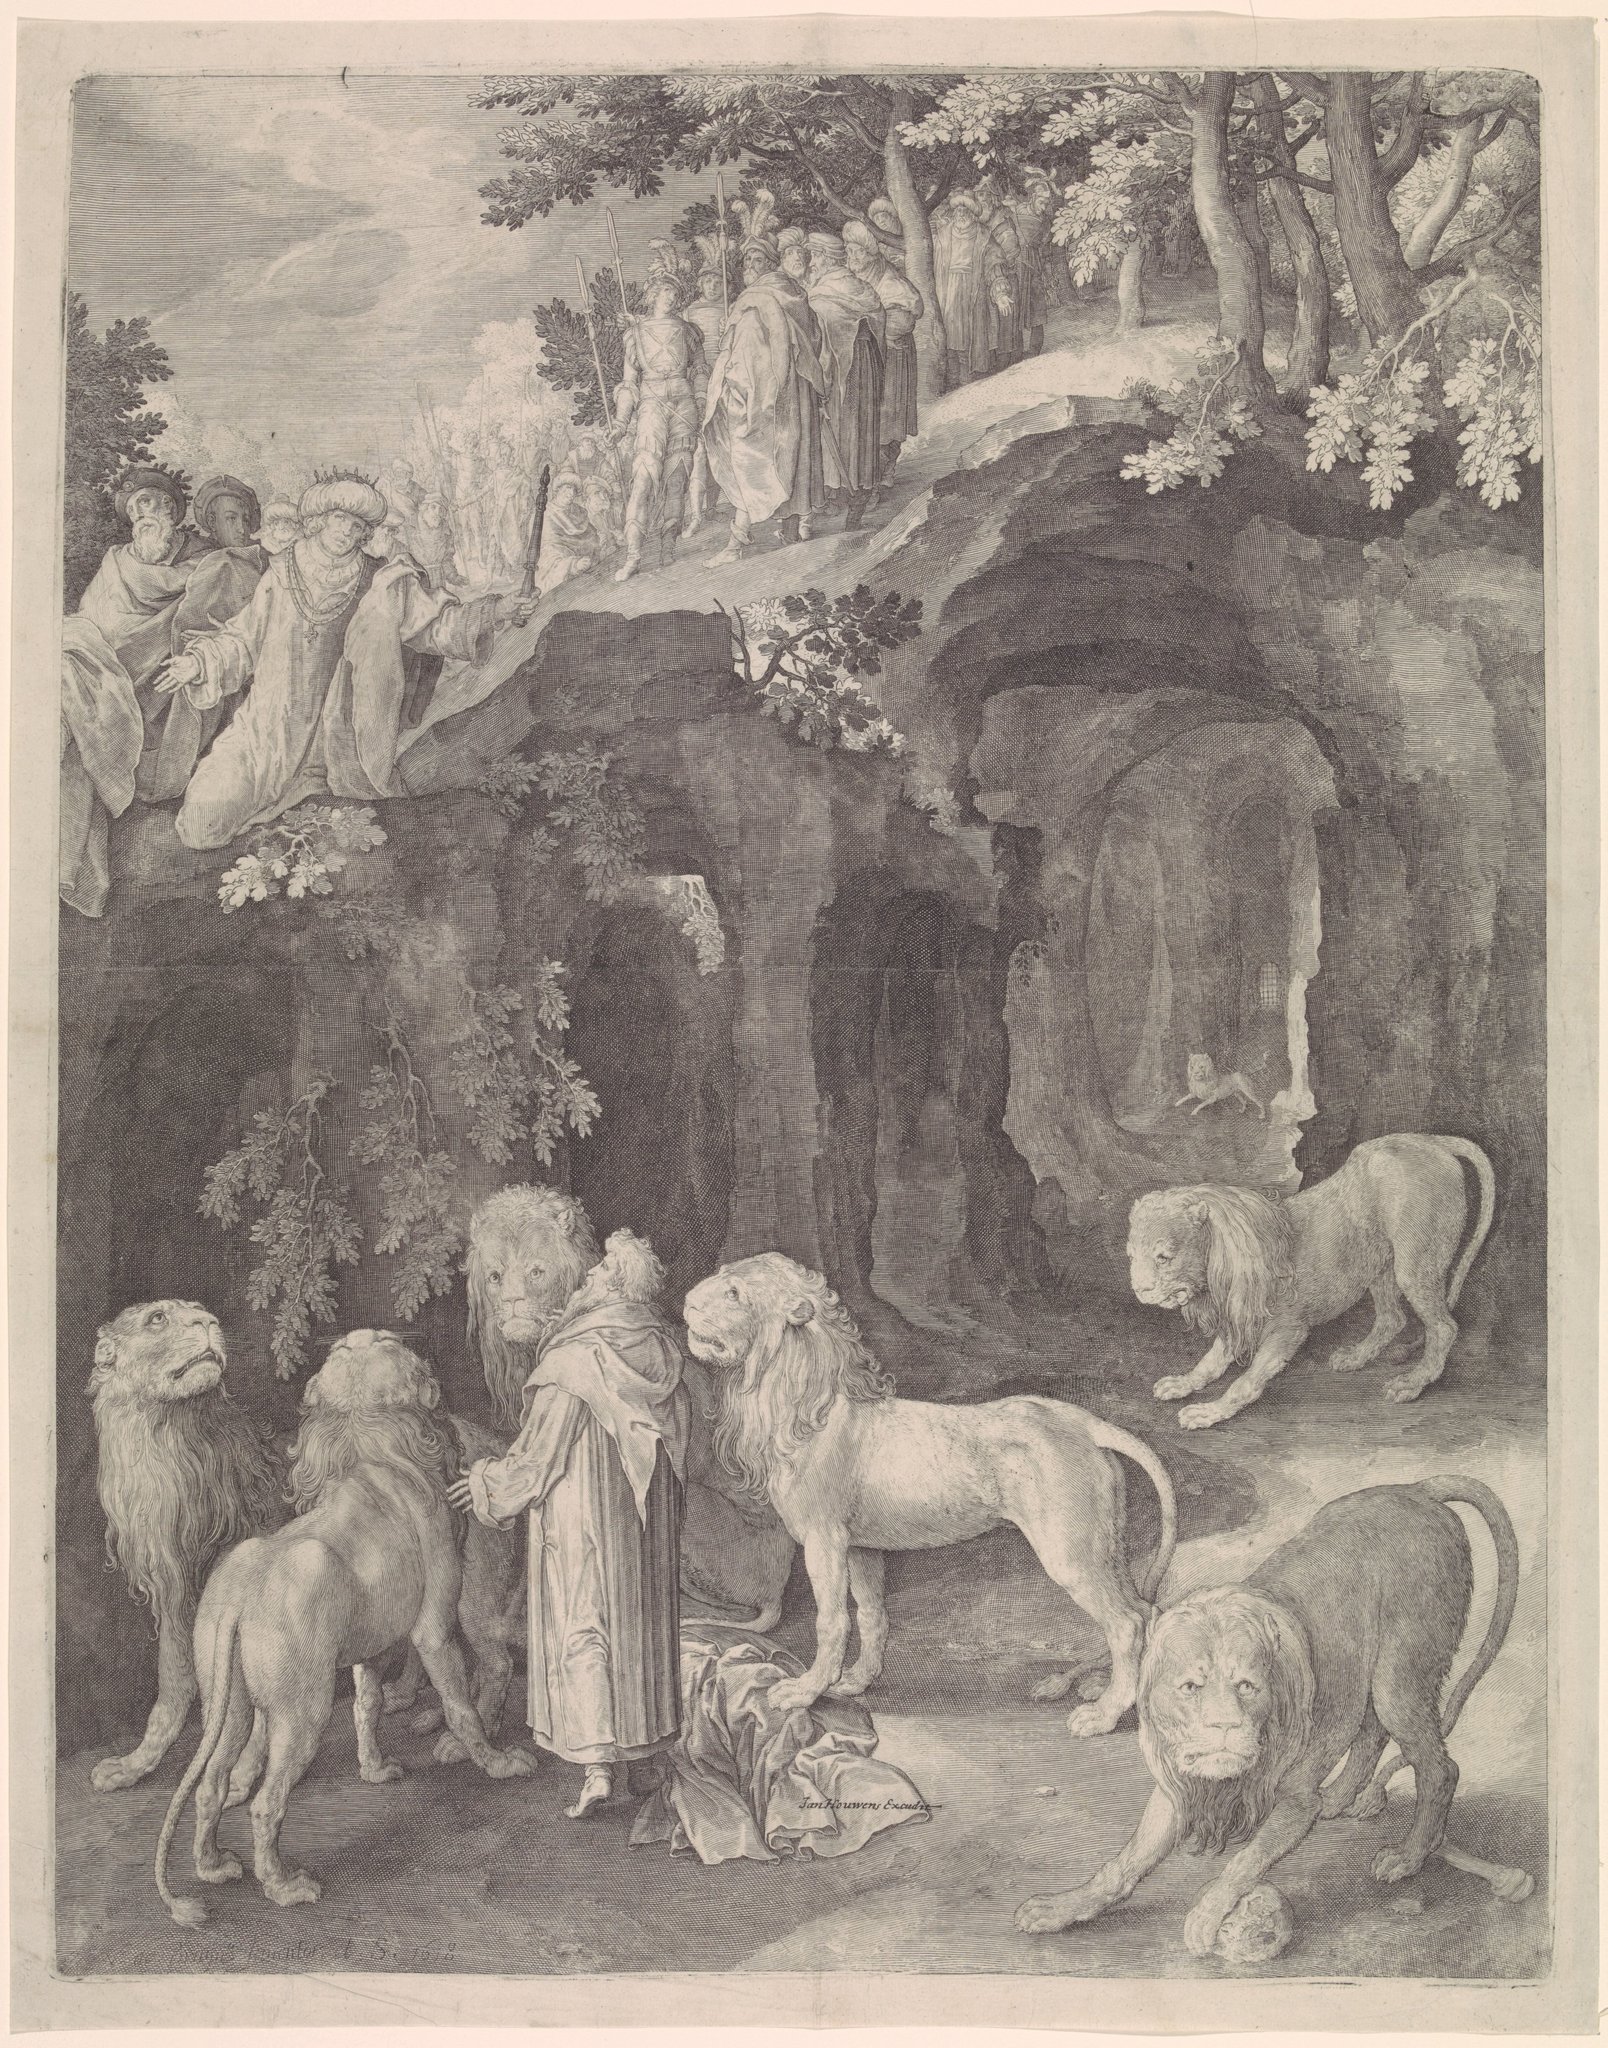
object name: print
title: Koning Darius vindt Daniël ongedeerd in leeuwenkuil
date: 1618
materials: paper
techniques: engraving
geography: rotterdam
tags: early in the morning king darius goes to the lion's den and finds daniel alive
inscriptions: collector's mark: Lugt 2228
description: Daniël staat in de leeuwenkuil, omringd door leeuwen. Koning Darius zit geknield aan de rand van de leeuwenkuil en is verheugd Daniël ongedeerd terug te vinden. Achter koning Darius zijn hofdienaren en soldaten.